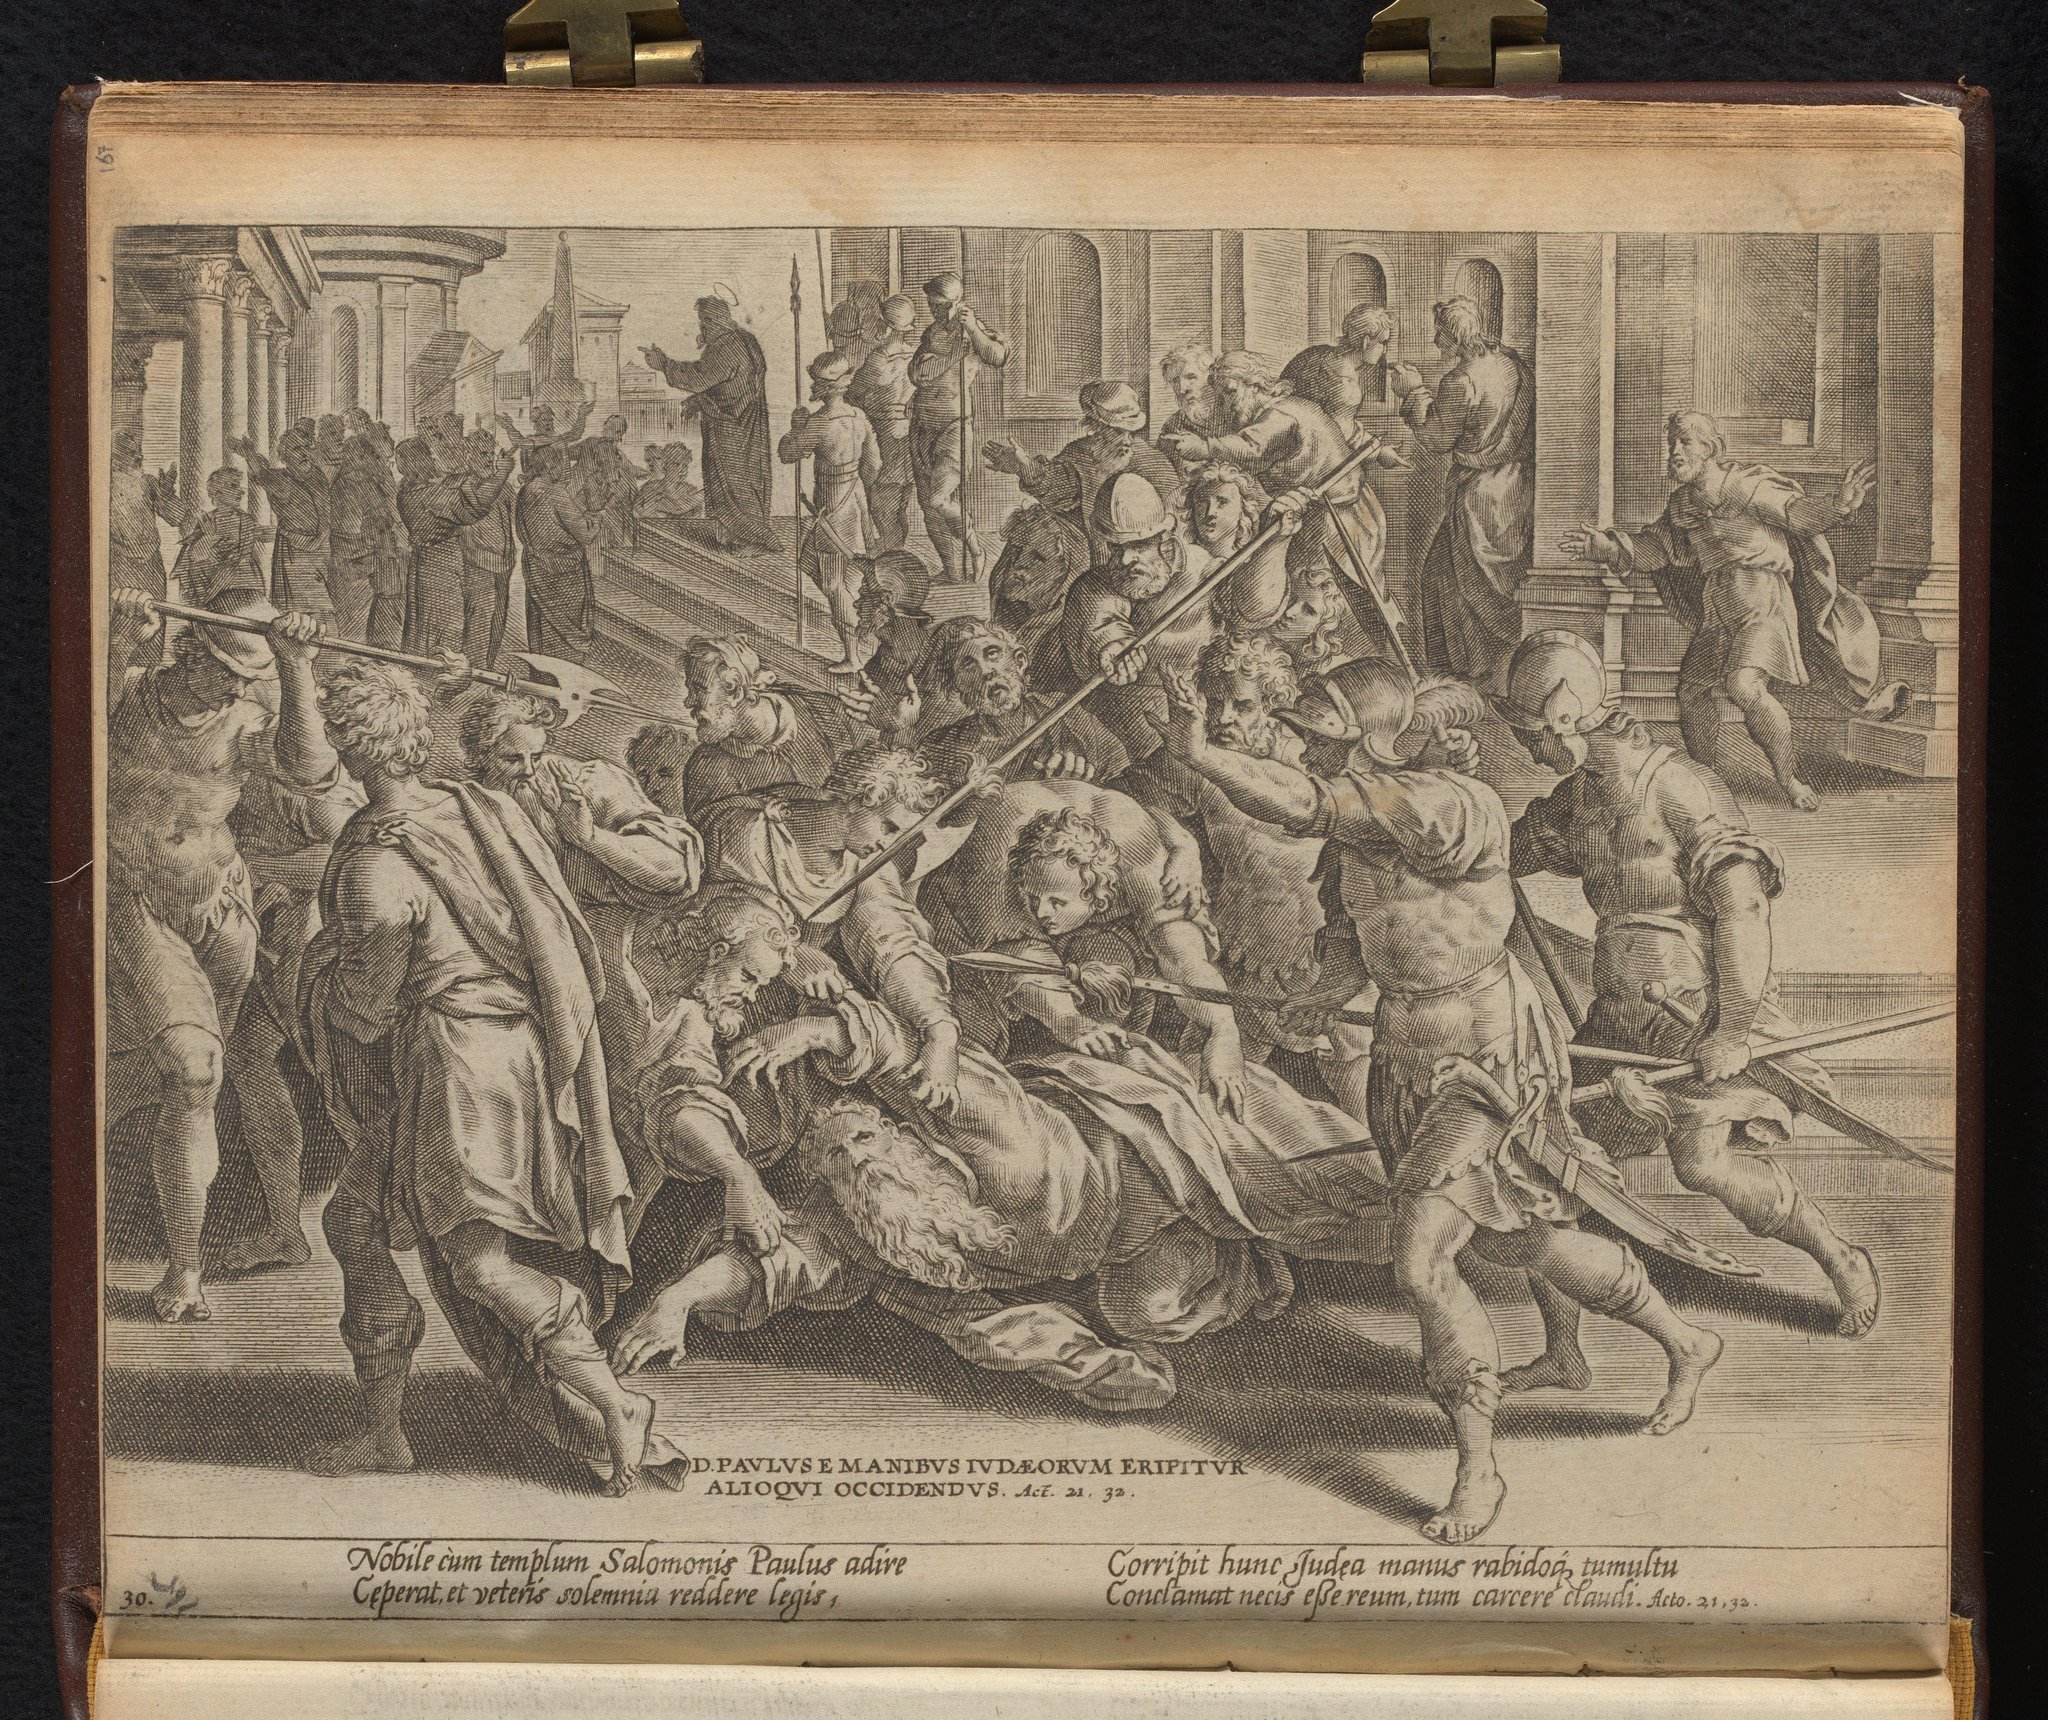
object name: titelprent, frontispice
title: Gevangenneming van Paulus in Jeruzalem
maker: philips galle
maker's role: print maker, publisher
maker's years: 1537-1612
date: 1582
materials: paper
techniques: engraving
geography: antwerp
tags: paul speaks to the people from the stairs, paul is dragged out of the temple by the jews; he is rescued by soldiers, who arrest him and carry him away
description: Prent maakt deel uit van een prentbijbel.